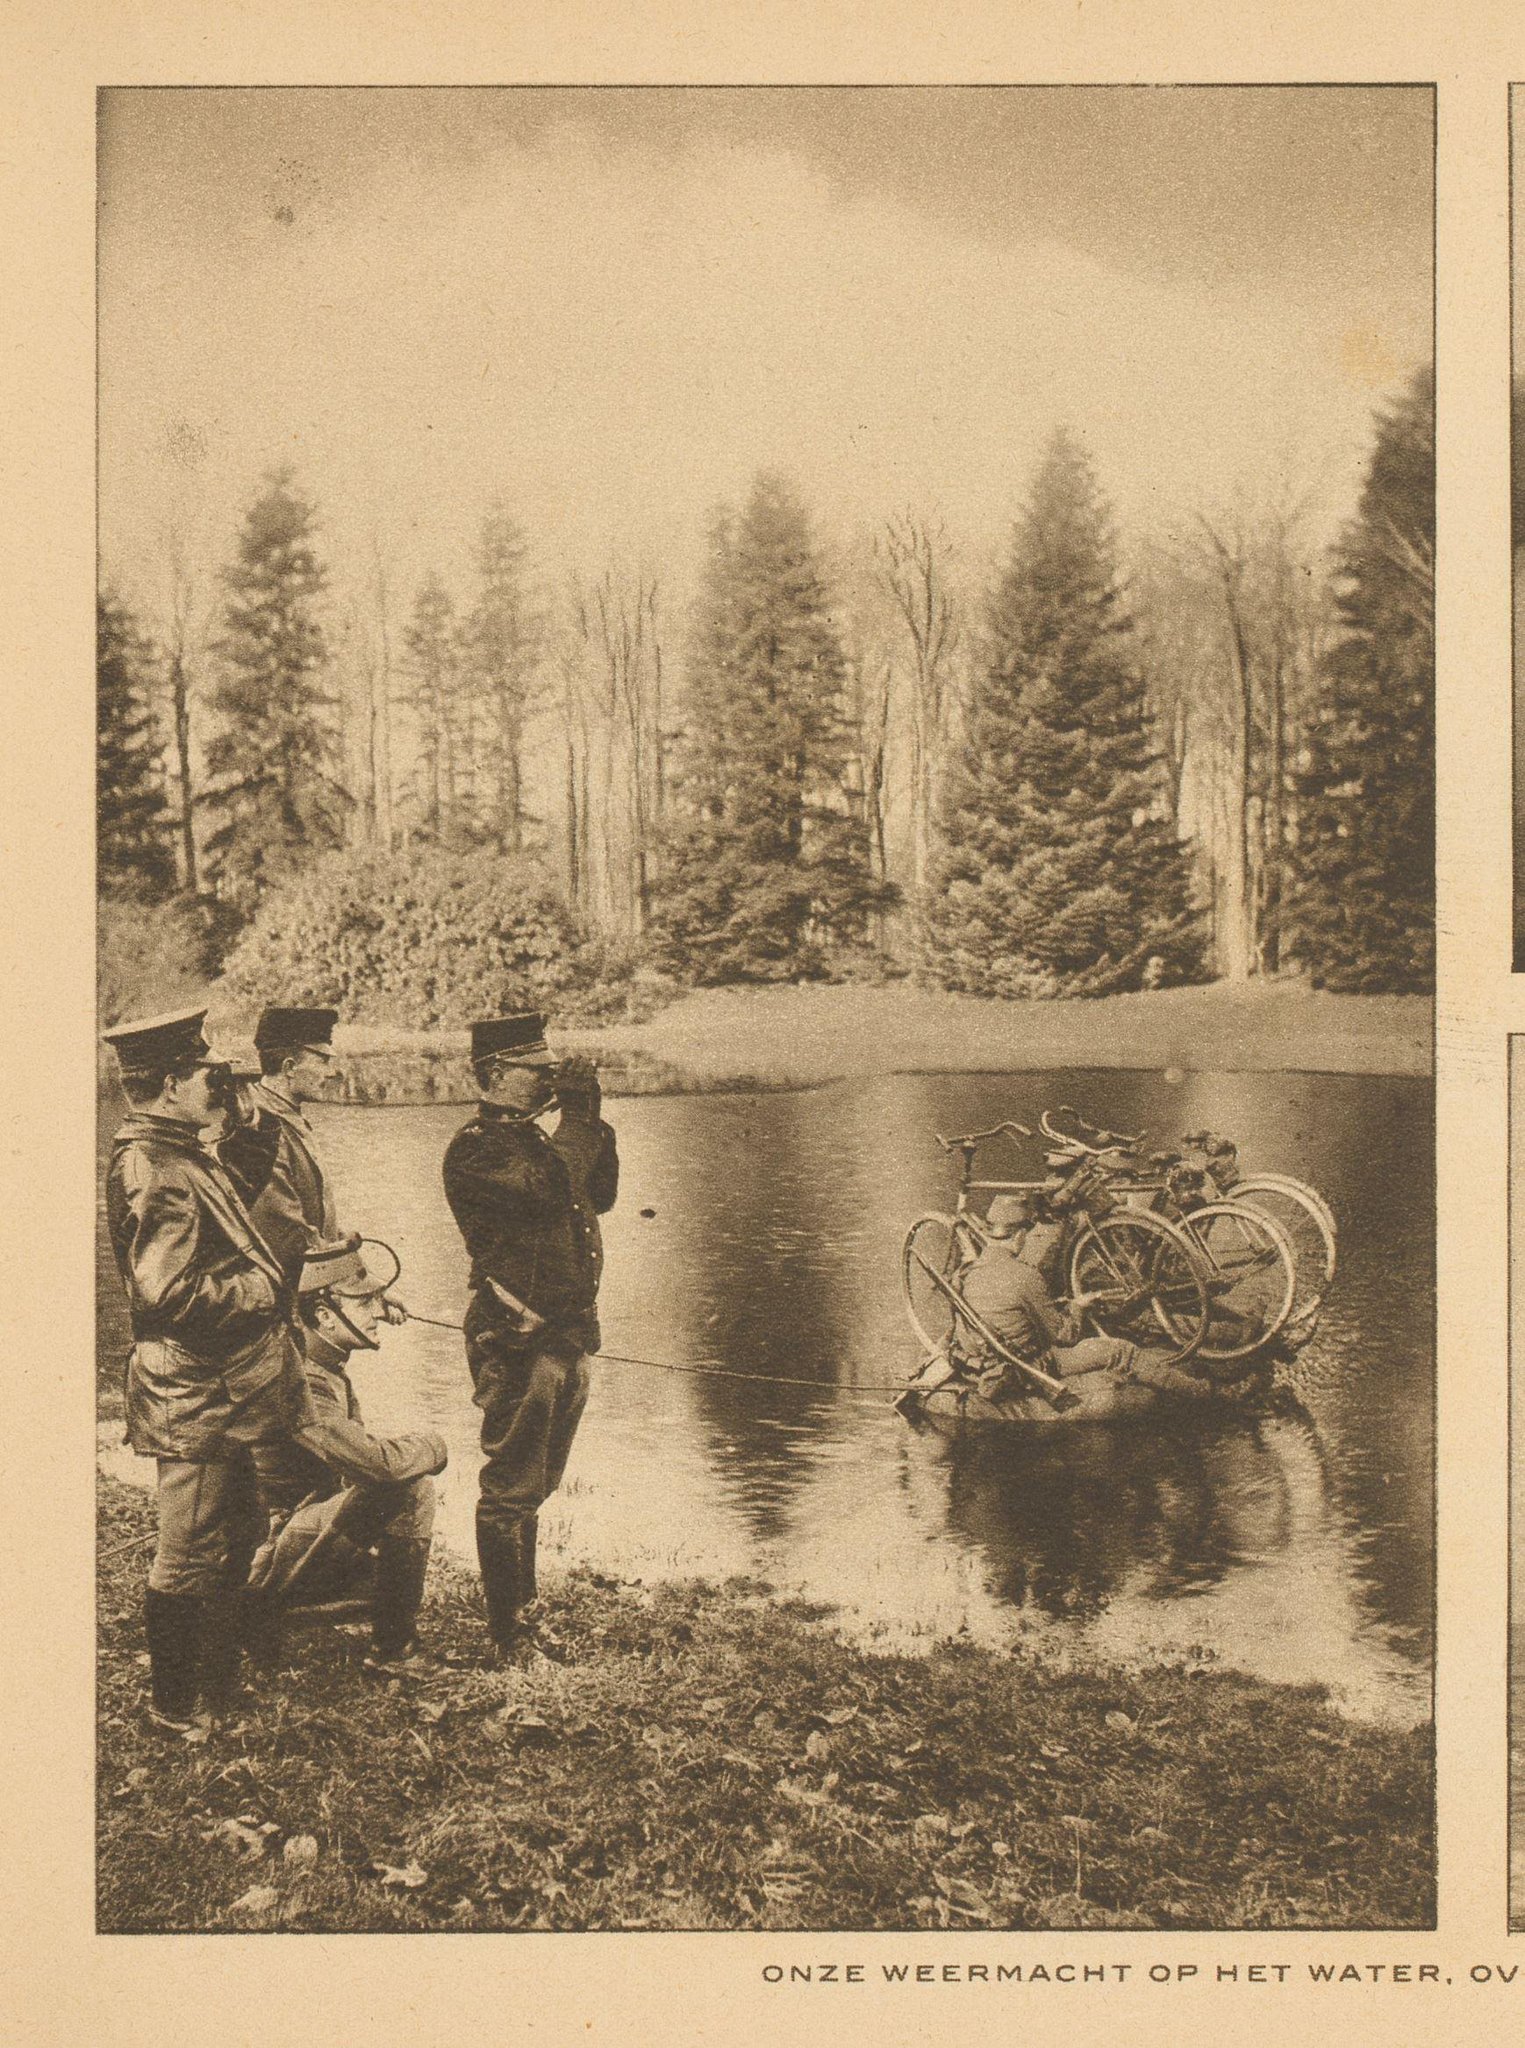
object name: album leaf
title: Onze weermacht op het water, over het water en onder water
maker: Anonymous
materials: paper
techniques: rotogravure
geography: leiden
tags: military training, bicycle, traffic on the water, netherlands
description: Deze prent maakt deel uit van een album.